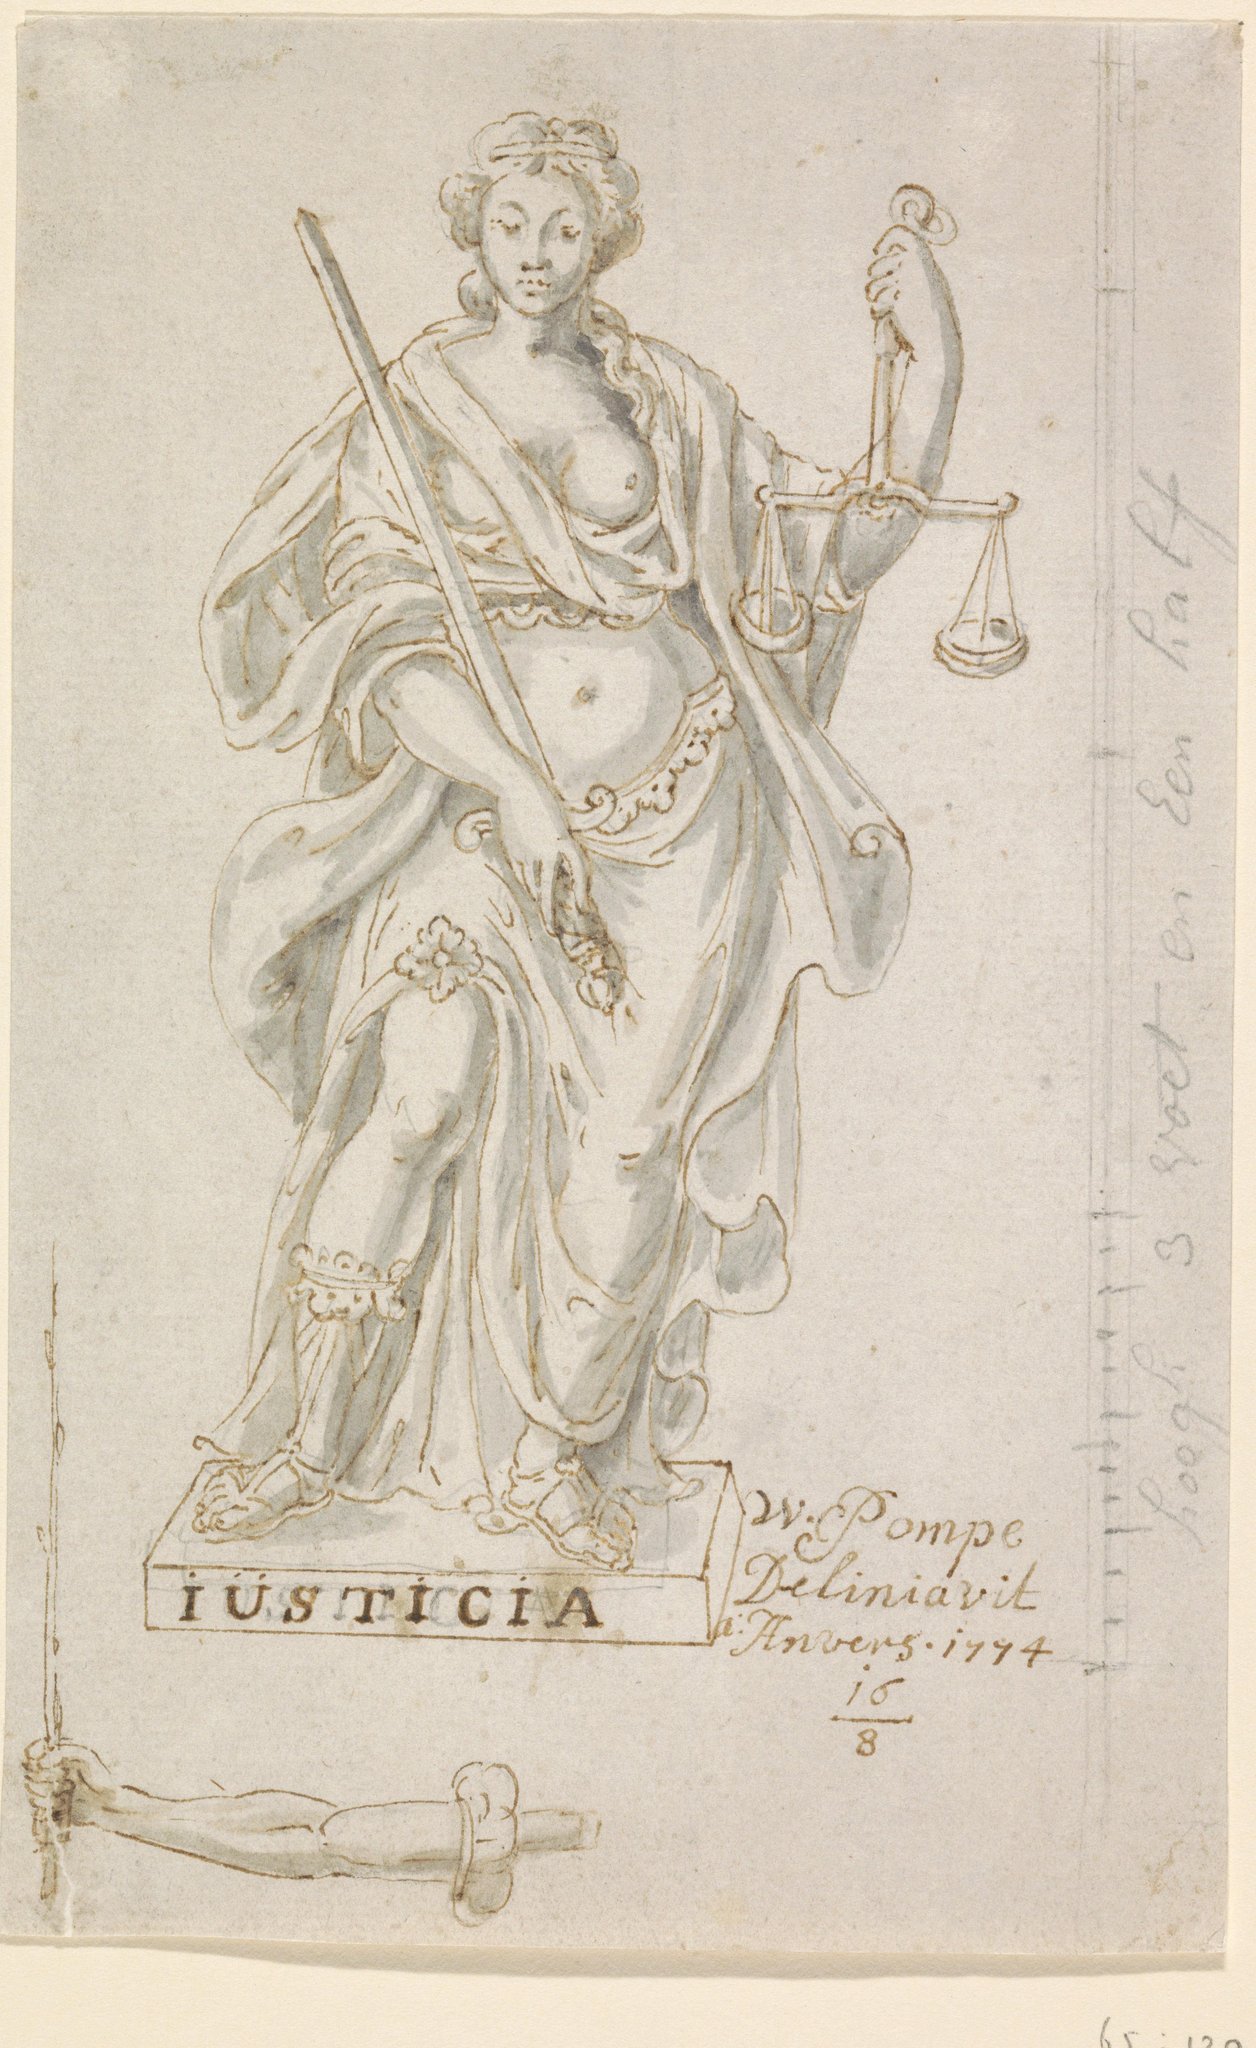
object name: ornamenttekening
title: Gerechtigheid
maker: walter pompe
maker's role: draughtsman, sculptor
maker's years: 1703-1777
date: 1774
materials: ink, paper, pencil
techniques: brush, pen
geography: antwerp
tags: justitia (justice) as roman personification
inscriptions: collector's mark: Lugt 2228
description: Een beeld van Vrouw Justitia met een zwaard en een weegschaal. Links onder een arm met een tak.